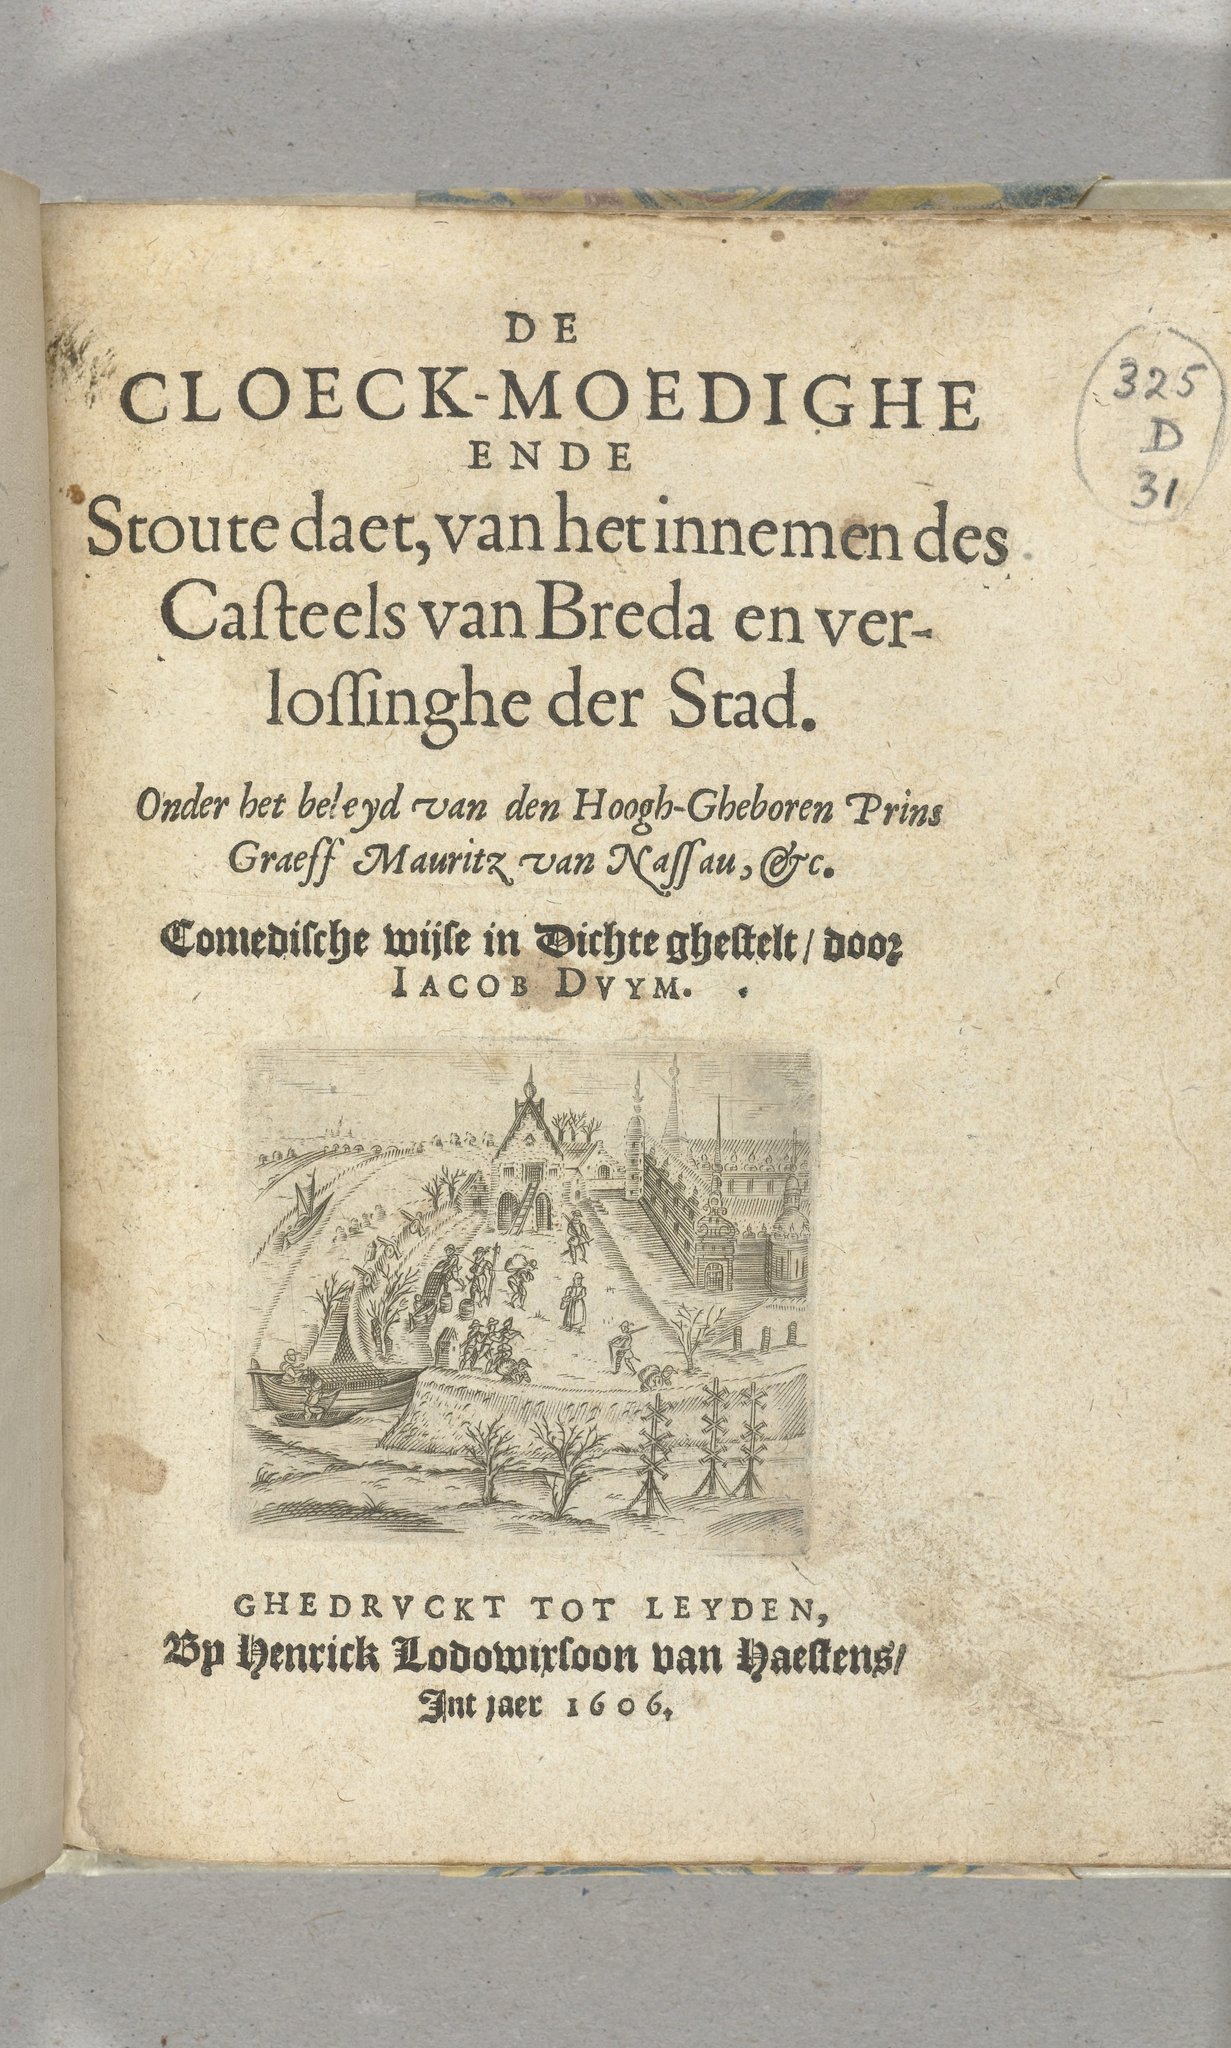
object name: titelblad, titelpagina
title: Vignet van de inname van Breda, 1590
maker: Anonymous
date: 1604-1606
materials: paper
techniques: engraving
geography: northern netherlands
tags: maurice (prince of orange), capture of city (after the siege)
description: Klein vignetje op de titelpagina met een voorstelling van de inname van Breda op 4 maart 1590. De soldaten komen uit het turfschip tevoorschijn.